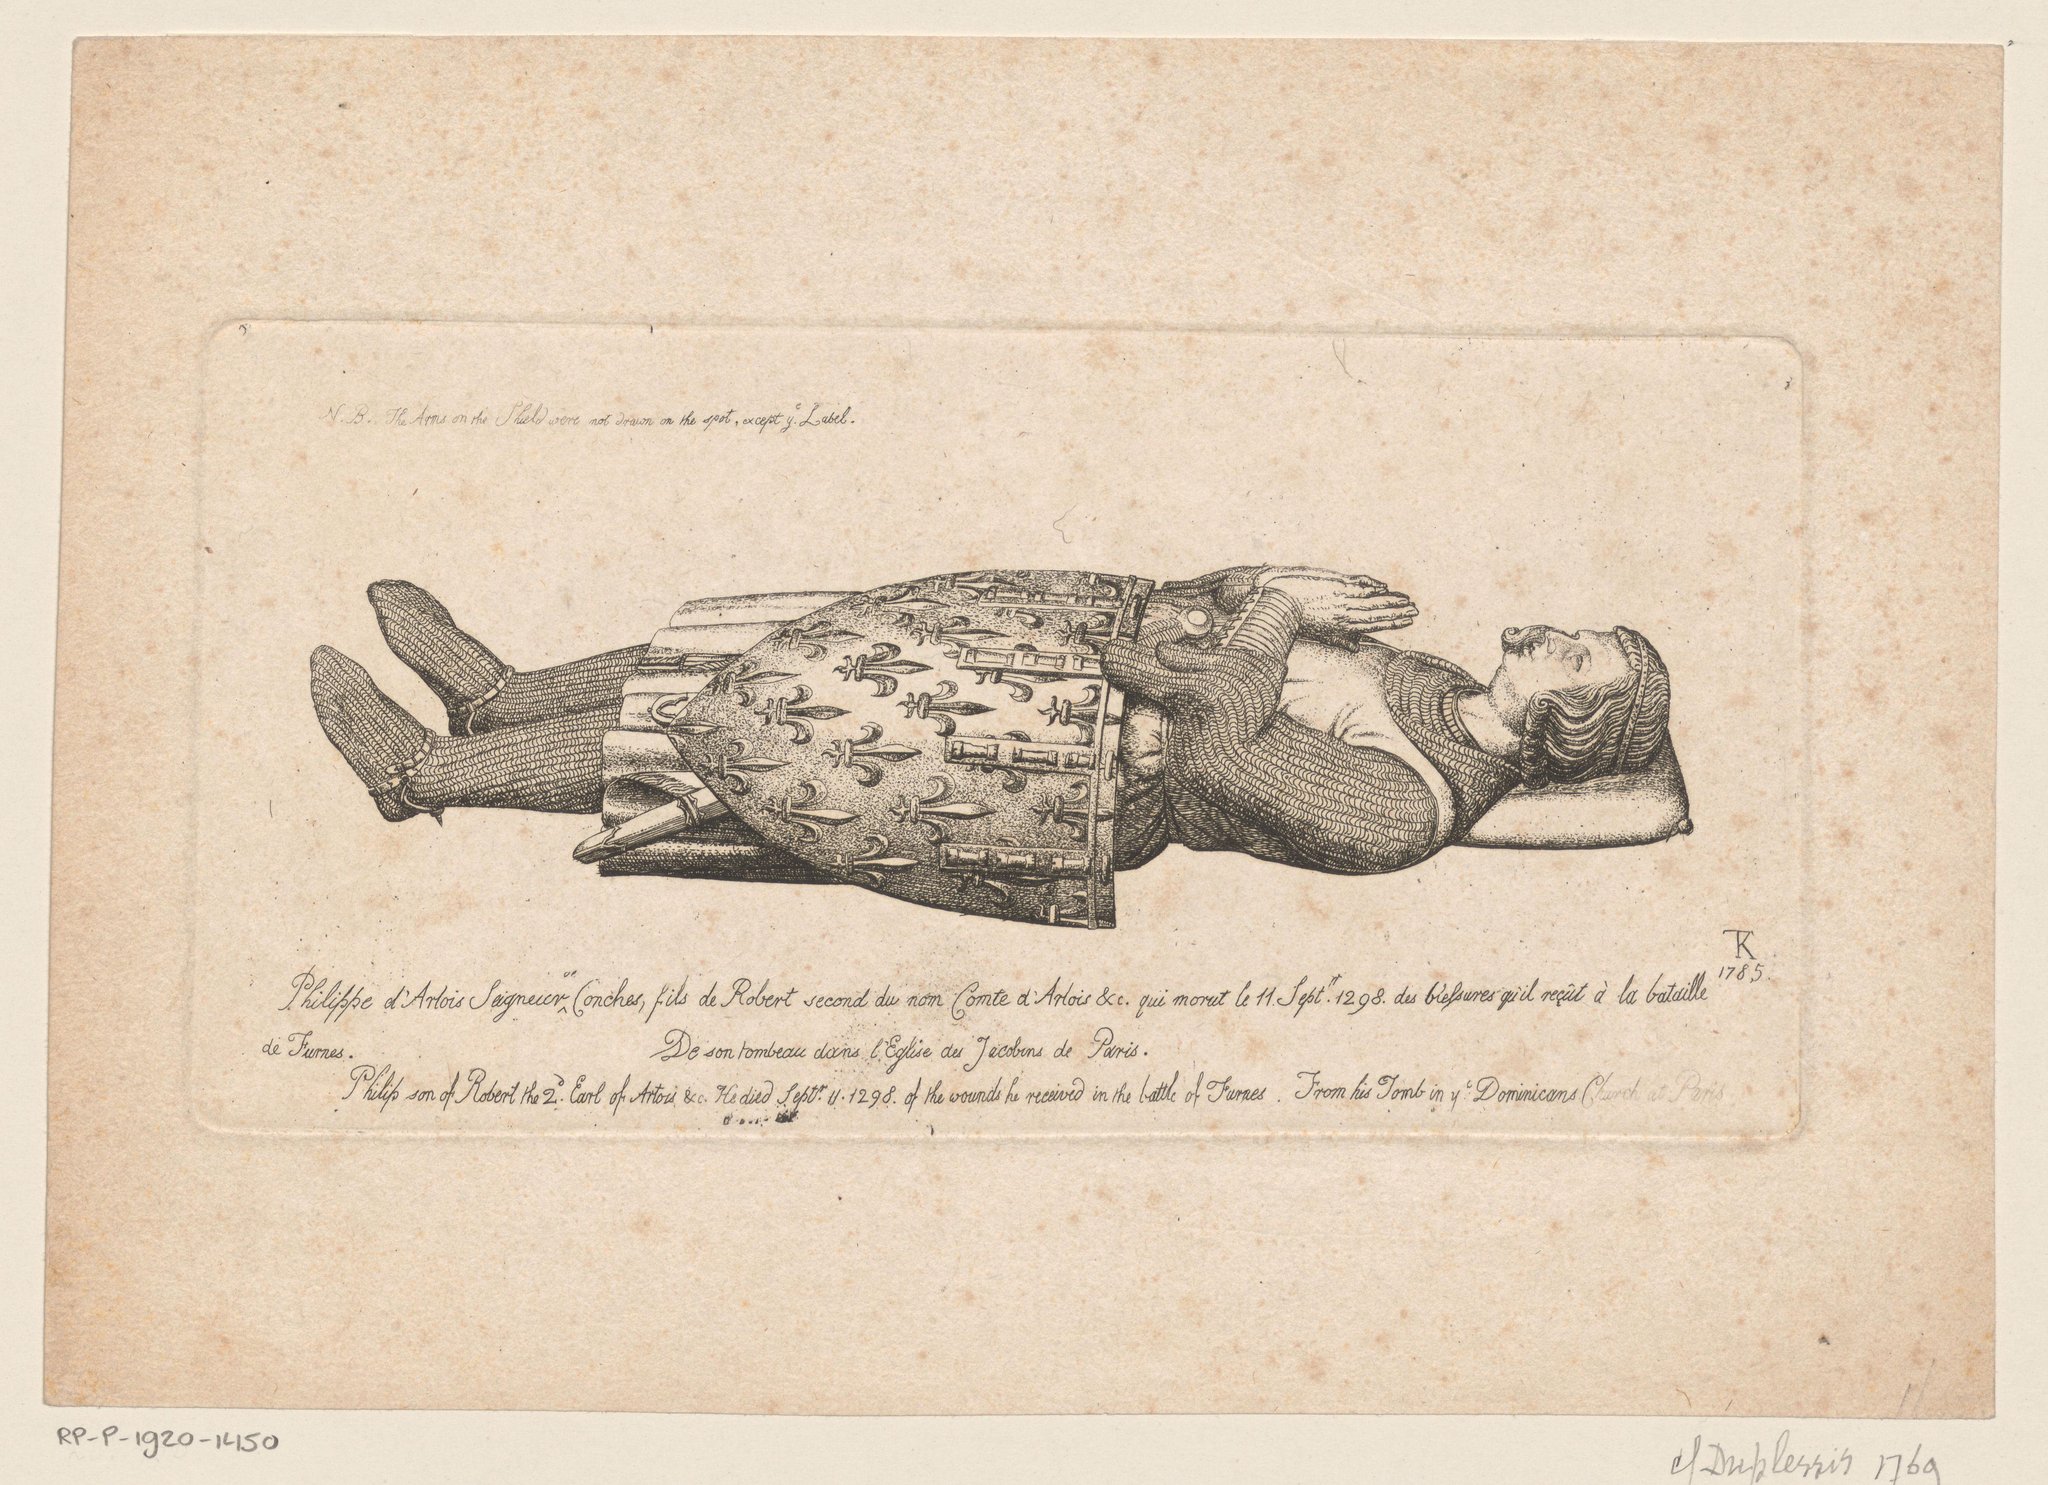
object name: print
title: Grafmonument van Philips van Artois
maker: monogrammist tk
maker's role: print maker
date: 1785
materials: paper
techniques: etching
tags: grave, tomb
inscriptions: collector's mark: Lugt 2228